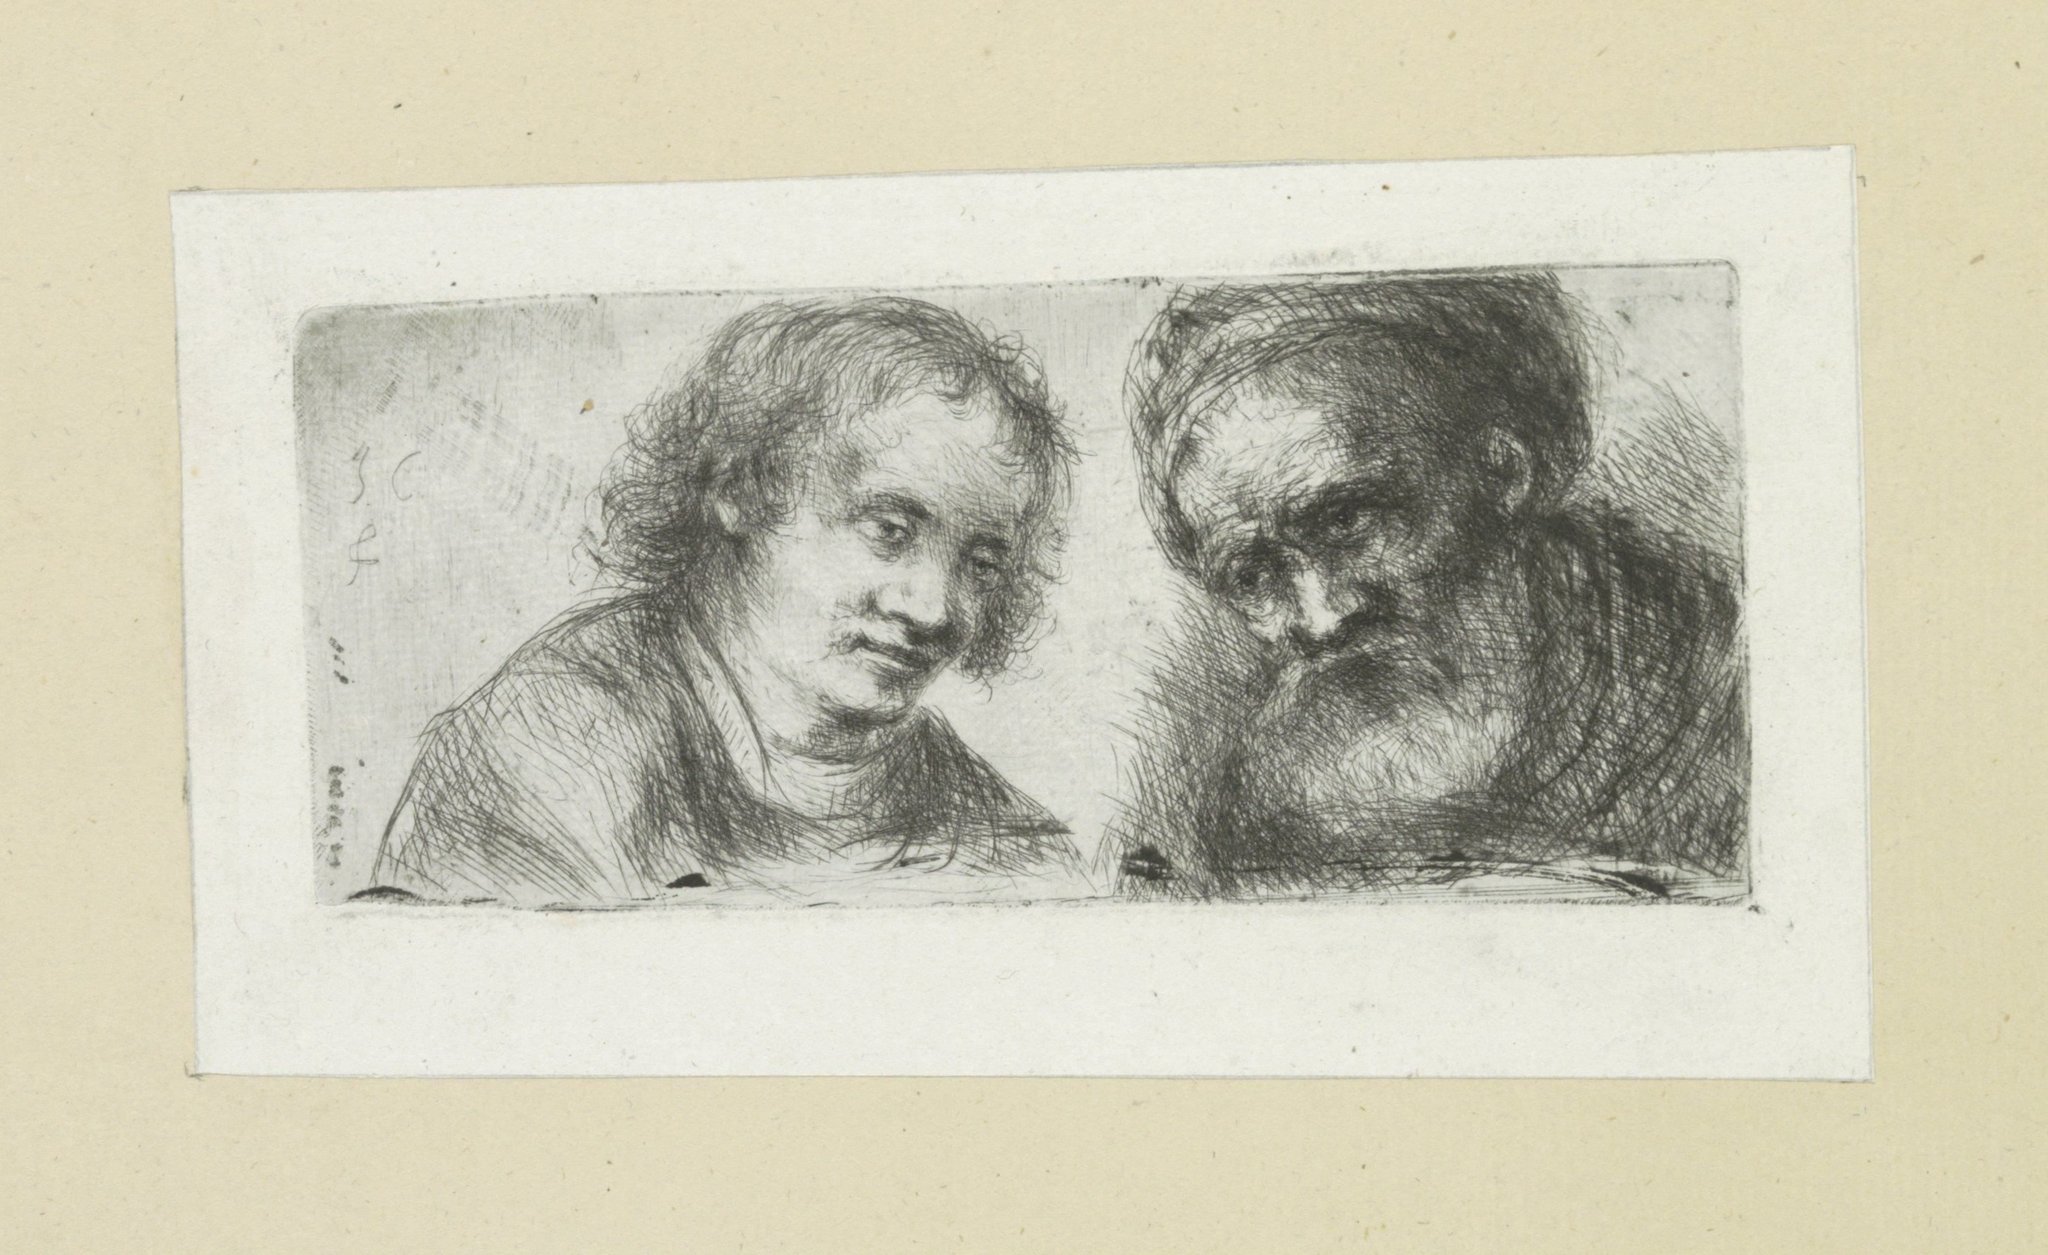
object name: album leaf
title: The Compleat Work of Etchings by John Chalon / Oeuvre Complette des Eaux Fortes par Jean Chalon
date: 1802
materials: paper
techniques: drypoint, etching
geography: london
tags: morphology of human expression (+ old male (human being)), morphology of human expression (+ young male (human being))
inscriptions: collector's mark: ‘RIJKS / MUSM’, collector's mark: ‘B’